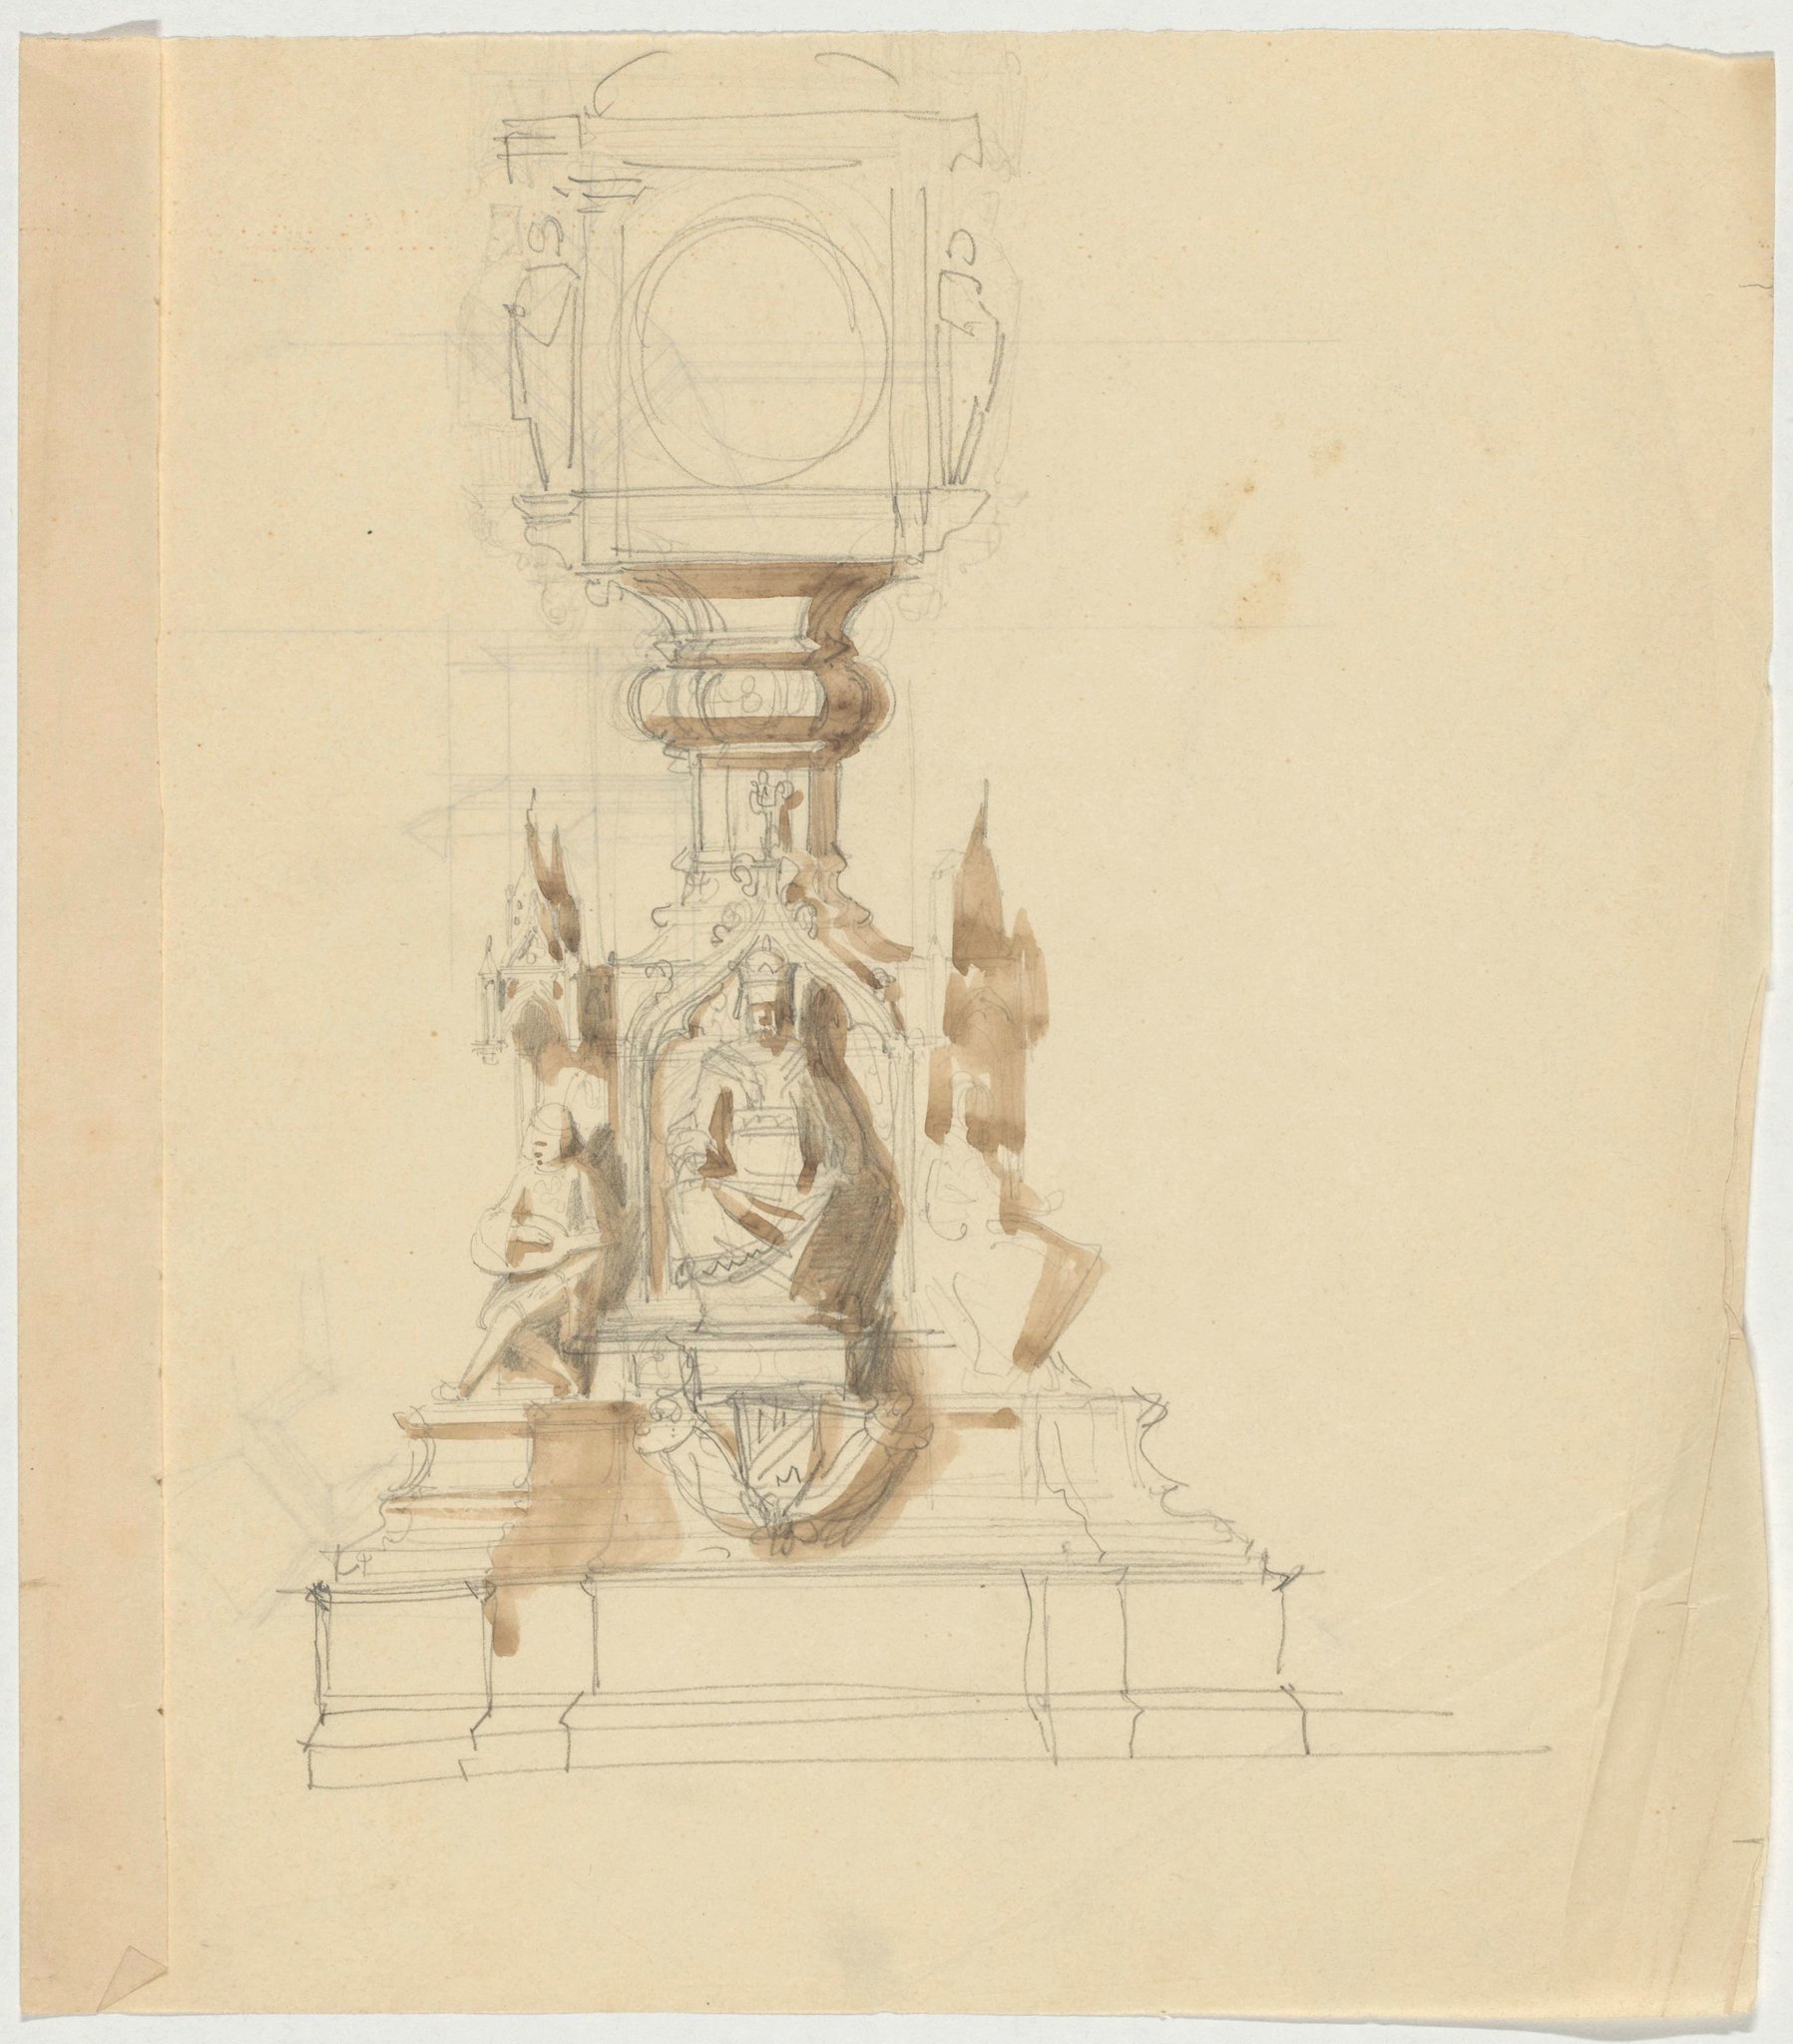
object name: design drawing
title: Klok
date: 1830-1850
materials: graphite, paper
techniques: brush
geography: paris